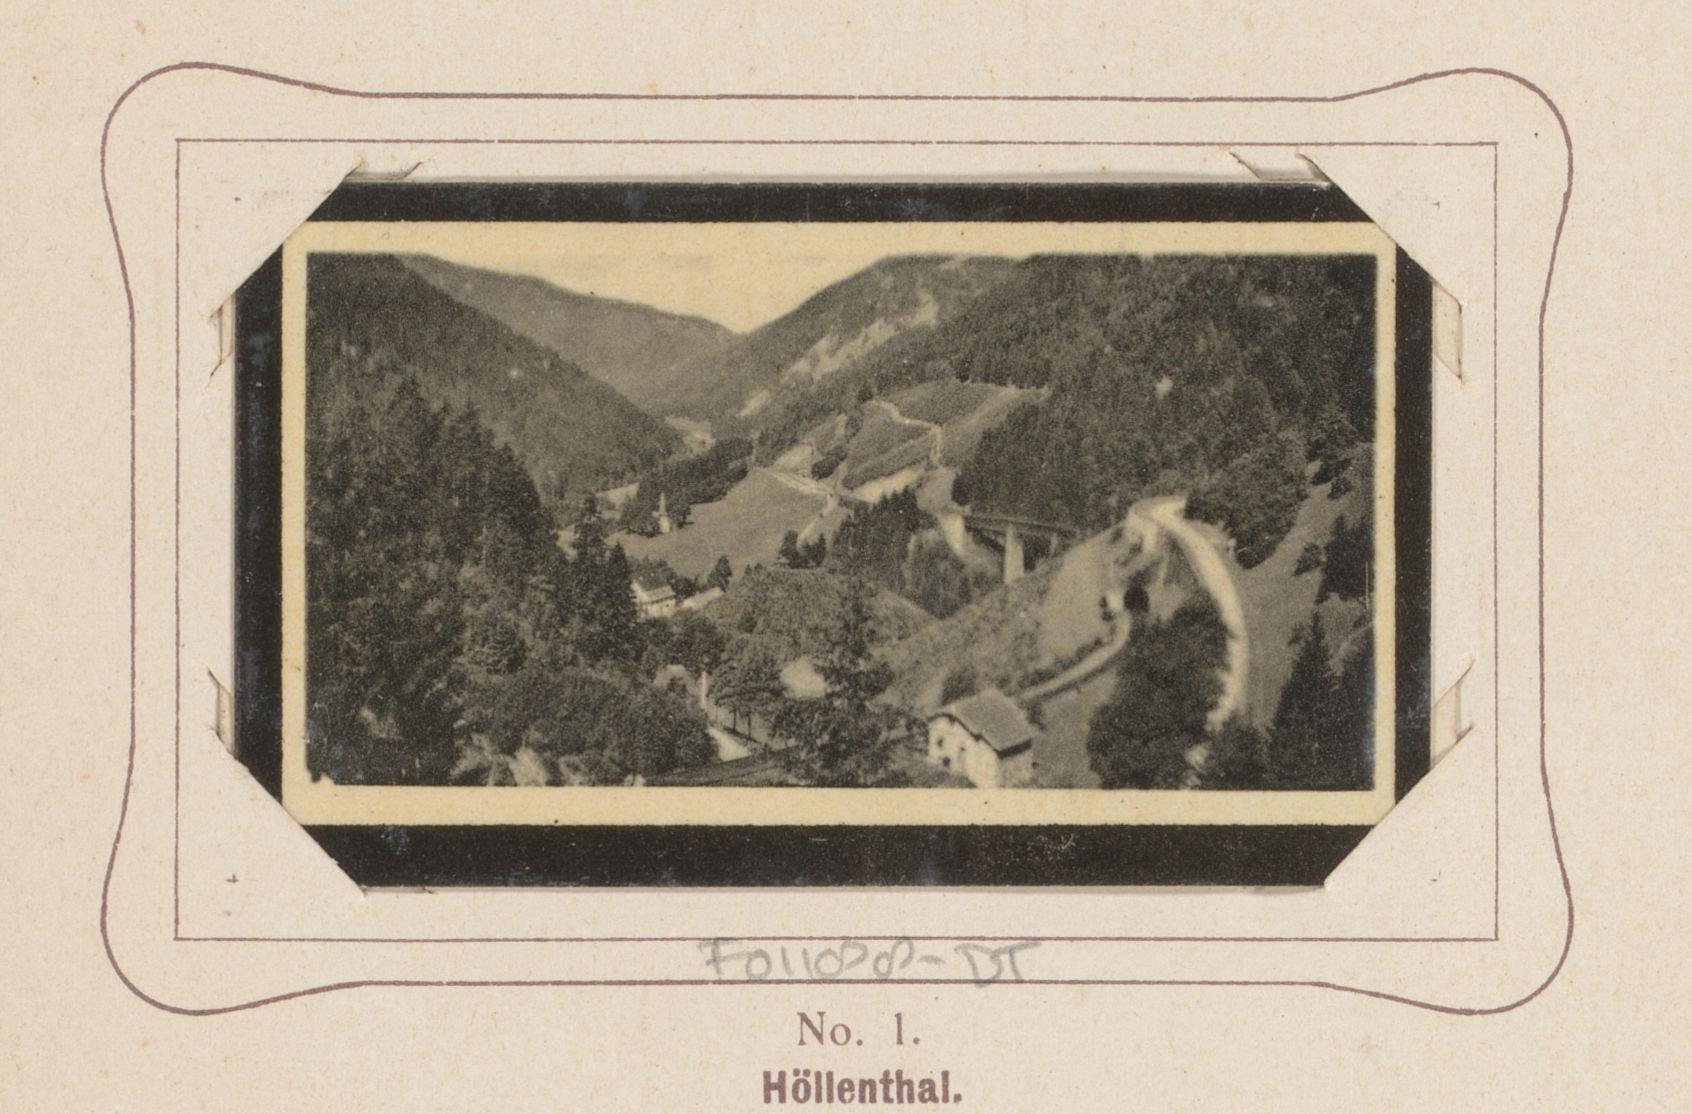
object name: album leaf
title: Gezicht op Höllental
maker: Anonymous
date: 1906-1907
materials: paper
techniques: photograph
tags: city-view in general; 'veduta'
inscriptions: inscription: ‘No. 1./ Höllental.’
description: Deze prent maakt deel uit van een album.